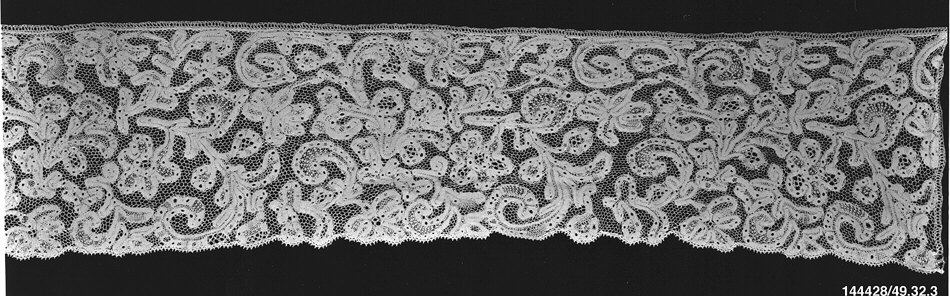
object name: border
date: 1601-1700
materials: lace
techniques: lace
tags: flowers